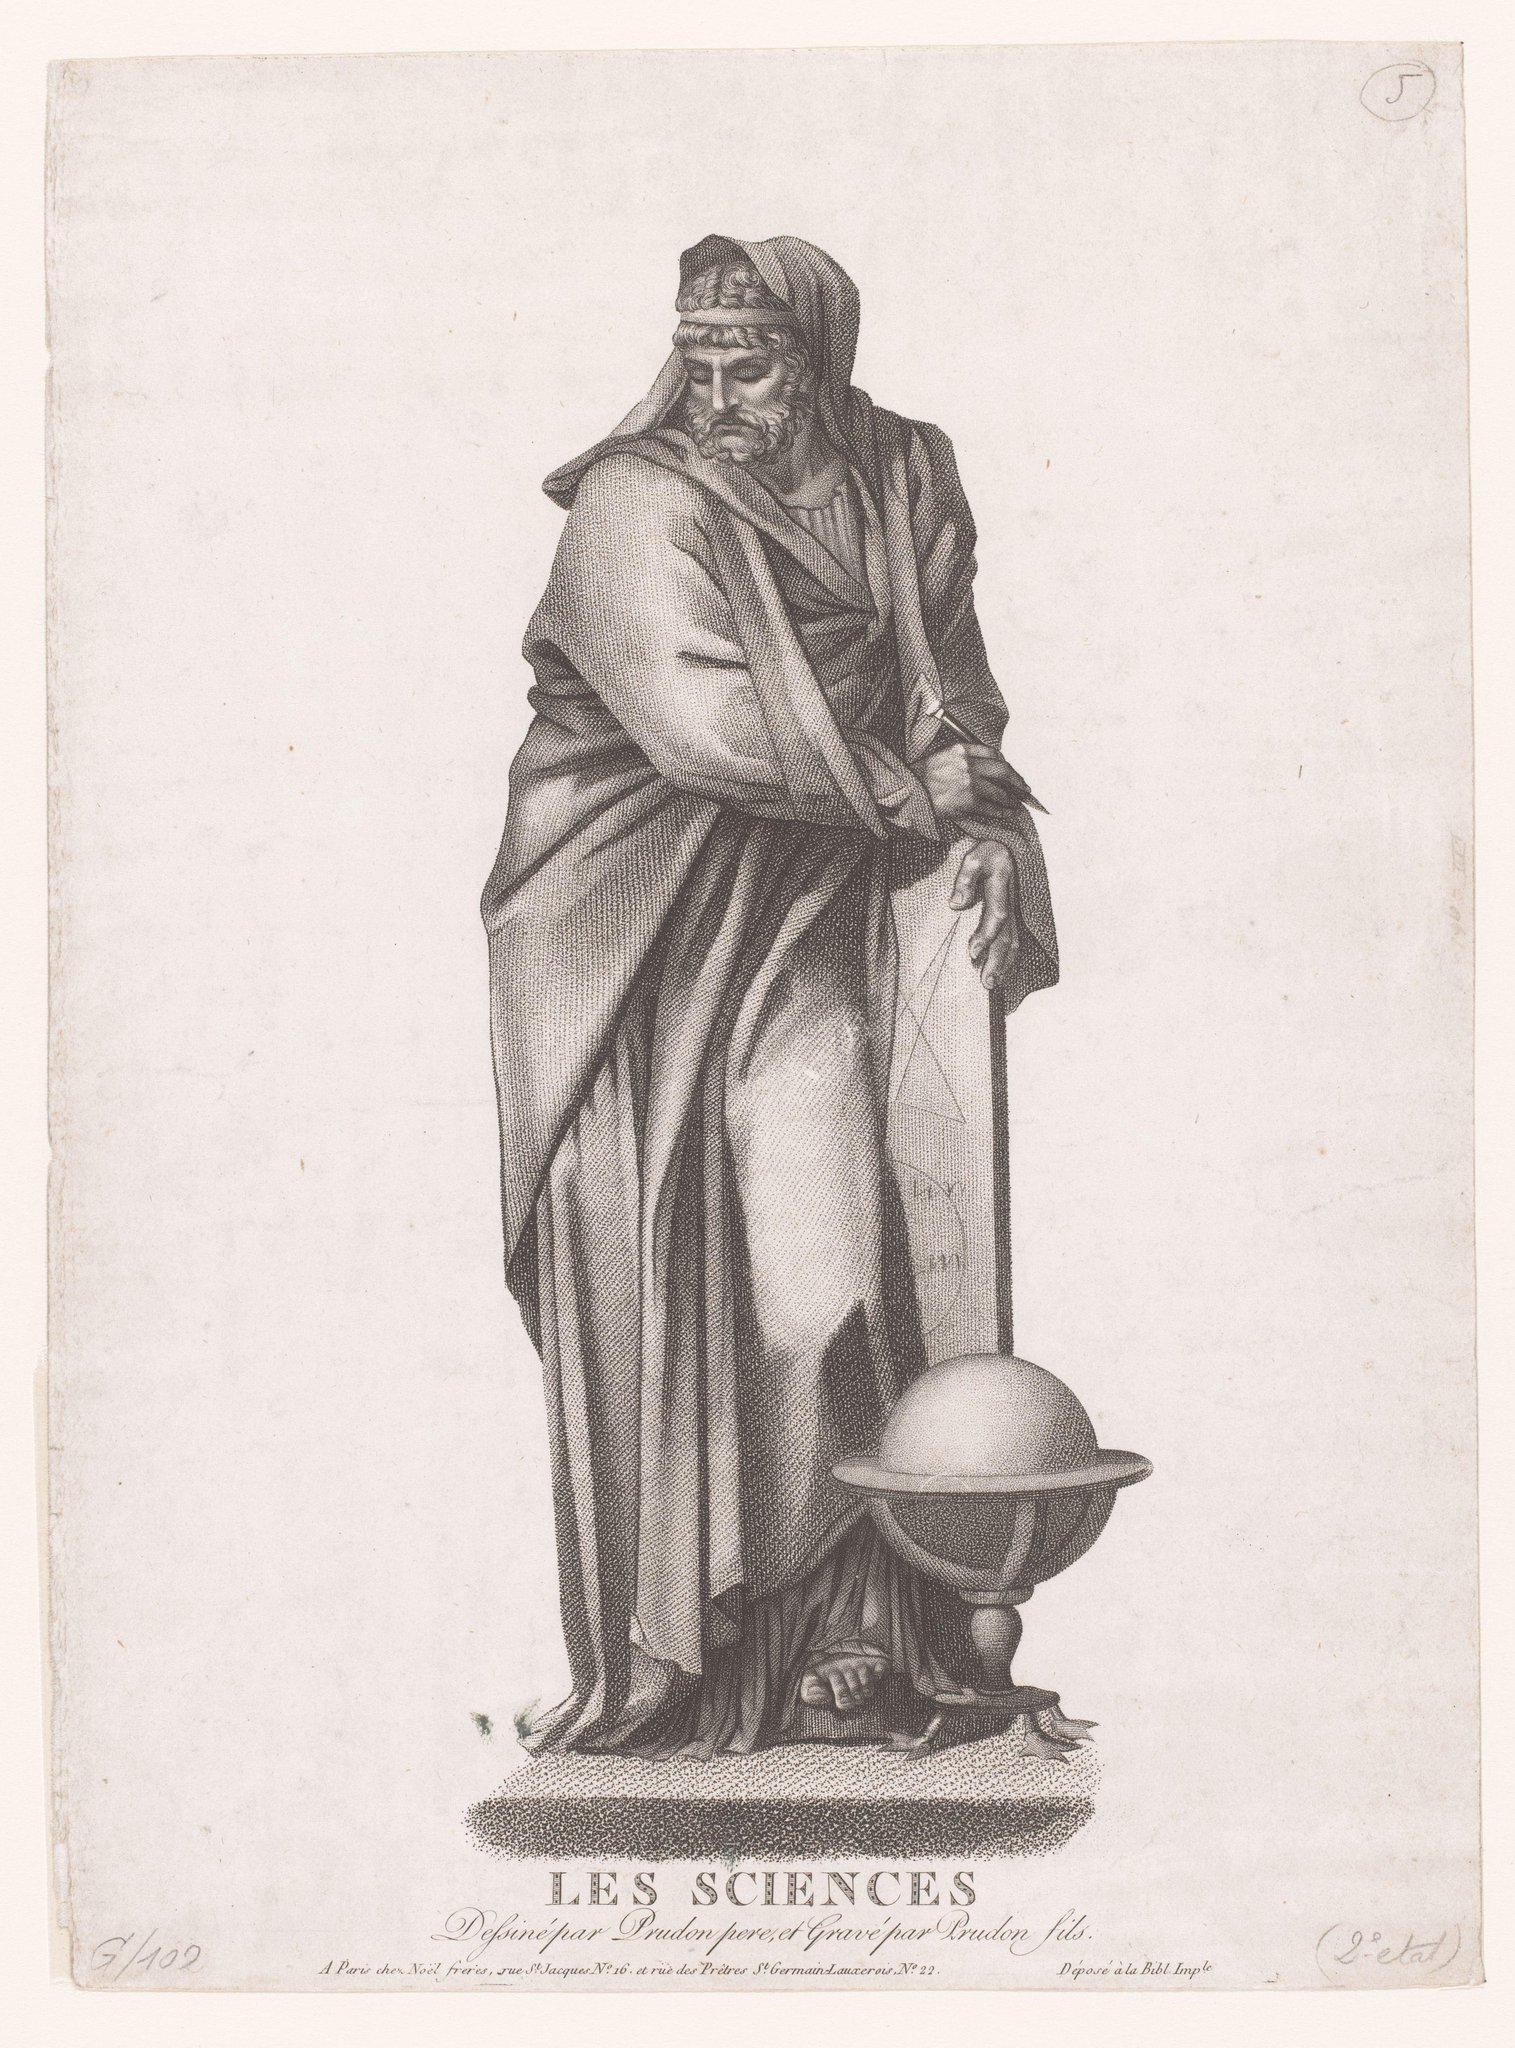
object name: print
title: Les Sciences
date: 1810-1823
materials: paper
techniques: engraving, etching, roulette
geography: paris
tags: symbolic representations, allegories and emblems ~ science, 'scientia'; 'scienza', 'studio' (ripa)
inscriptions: collector's mark: Lugt 2228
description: Serie naar de figuren die als decoratie gebruikt zijn in het stadhuis, tijdens het huwelijk van Napoleon I Bonaparte en Marie Louise van Oostenrijk in 1810.